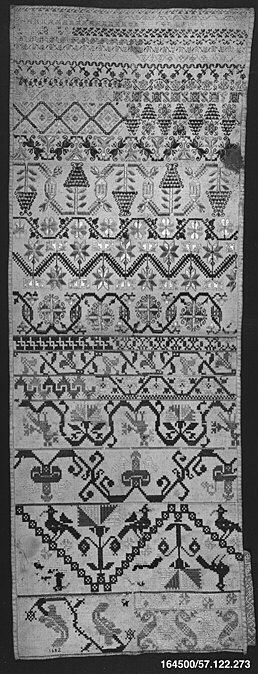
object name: sampler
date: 1701-1800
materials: linen, silk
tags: flowers